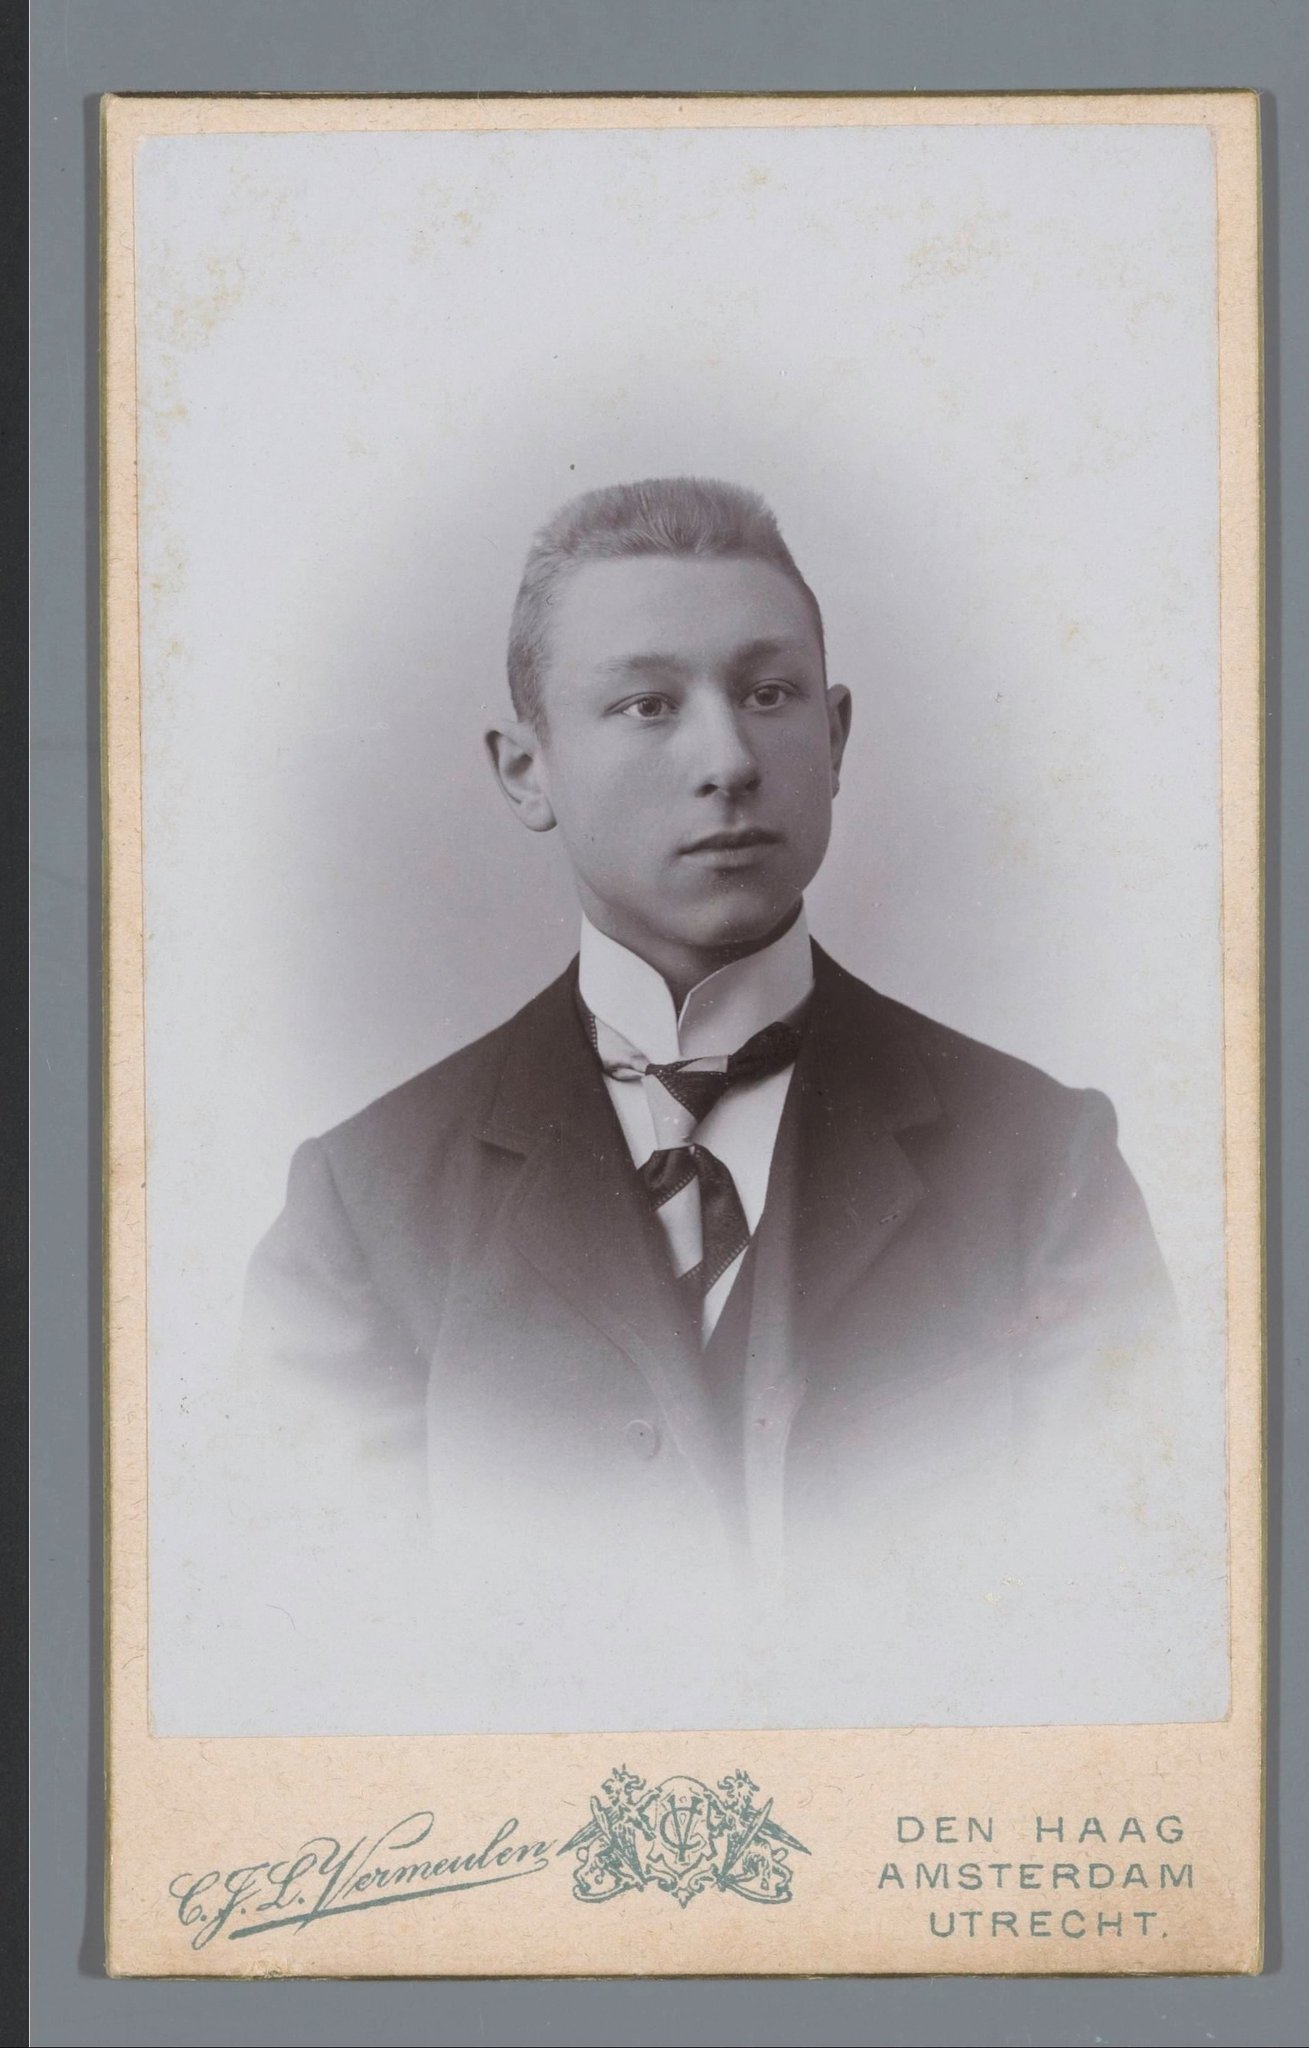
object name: photograph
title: Portret van een onbekende man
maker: cornelis johannes lodewicus vermeulen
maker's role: fotograaf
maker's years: 1861-1936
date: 1890-1915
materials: cardboard, photographic support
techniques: collodion silver print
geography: the hague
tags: historical persons, youth, adolescent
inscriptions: inscription: ‘CV/ C. J. L. Vermeulen/ DEN HAAG/ Toussaintkade 11./ Intercommunal Telephoon: 774./ AMSTERDAM/ Heiligenweg hoek Singel./ Telephoon No 2340./ UTRECHT/ Nieuwe gracht 50./ Telephoon No 750./ BLOCK & Co. BERLIN S.W.’, inscription: ‘09568/ 6’